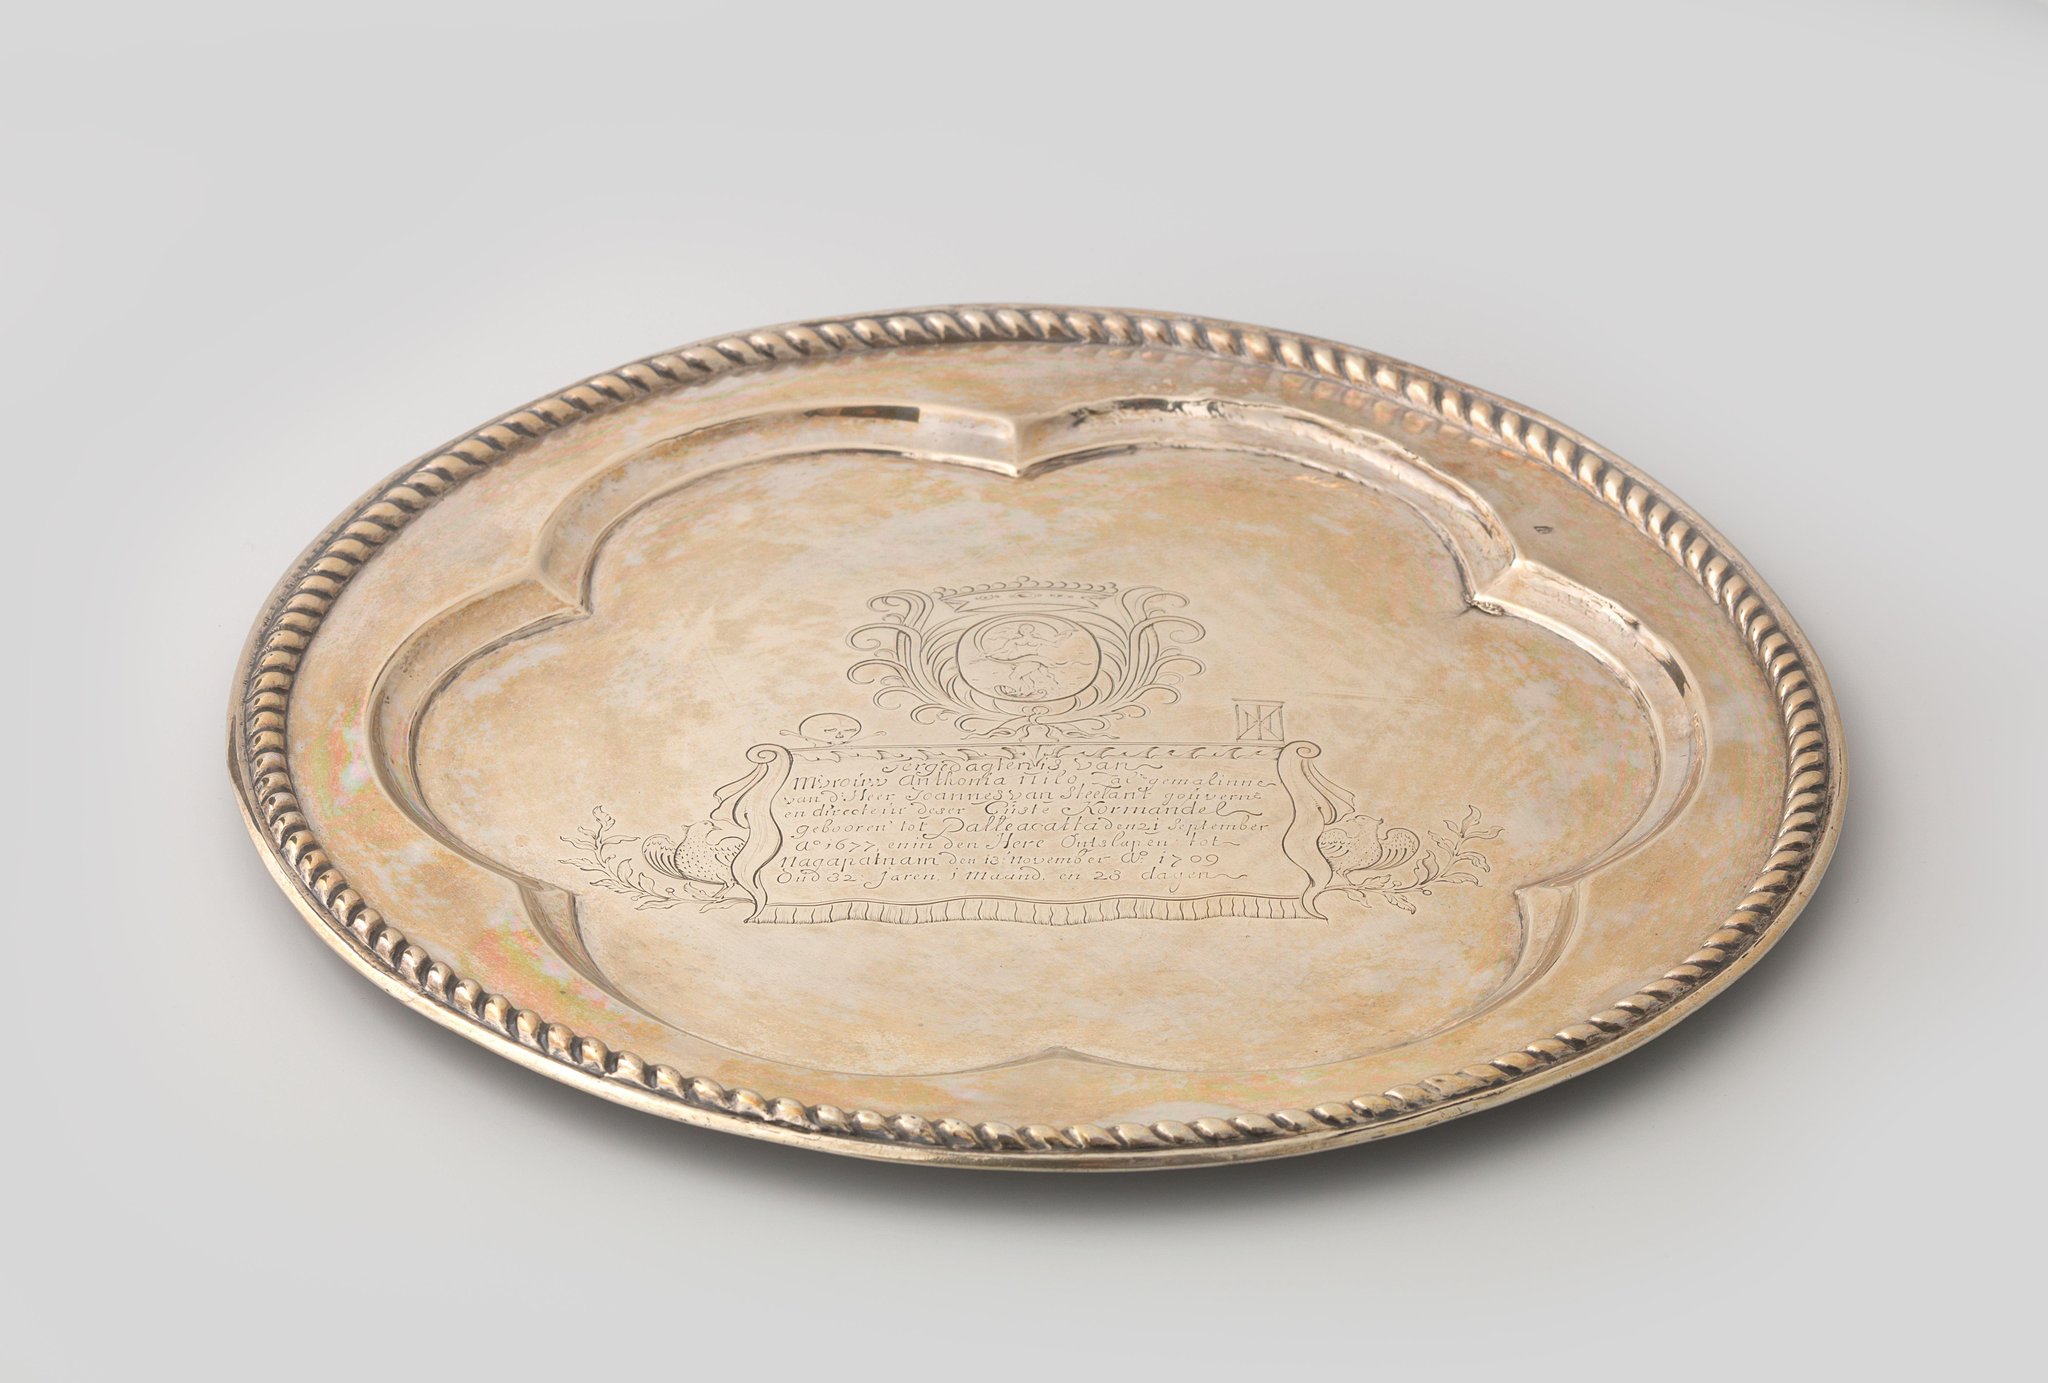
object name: gedachtenisbord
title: Schenkpiring ter nagedachtenis van Anthonia Nilo, echtgenote van Joannes van Steelant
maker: Anonymous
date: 1709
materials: silver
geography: nagapattinam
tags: anthonia nilo, johannes van steelandt, verenigde oostindische compagnie, negapatnam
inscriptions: inscription: ‘Ter gedagtenis van M'vrouw Anthonia Nilo zal'r gemalinne van d'Heer Joannes van Steelant gouverneur en directeur deser Custe Koromandel geboren te Palleacatte den 21 September A° 1677 en in den Here ontslapen tot Negapatnam den 13 November A° 1709 oud 32 jaren 1 maand en 23 dagen Ter gedagtenis van M'vrouw Anthonia Nilo zal'r gemalinne van d'Heer Joannes van Steelant gouverneur en directeur deser Custe Koromandel geboren te Palleacatte den 21 September A° 1677 en in den Here ontslapen tot Negapatnam den 13 November A° 1709 oud 32 jaren 1 maand en 23 dagen’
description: Ronde schenkpiring met een rand van knermotieven. Verdiept middendeel met zes lobben. Centraal tekst op draperie, vastgehouden door twee duiven op een tak. Middenboven de tekst: gekroond wapen tussen twee gestileerde ranken. Links en rechts hiervan respectievelijk een doodshoofd en een zandloper.